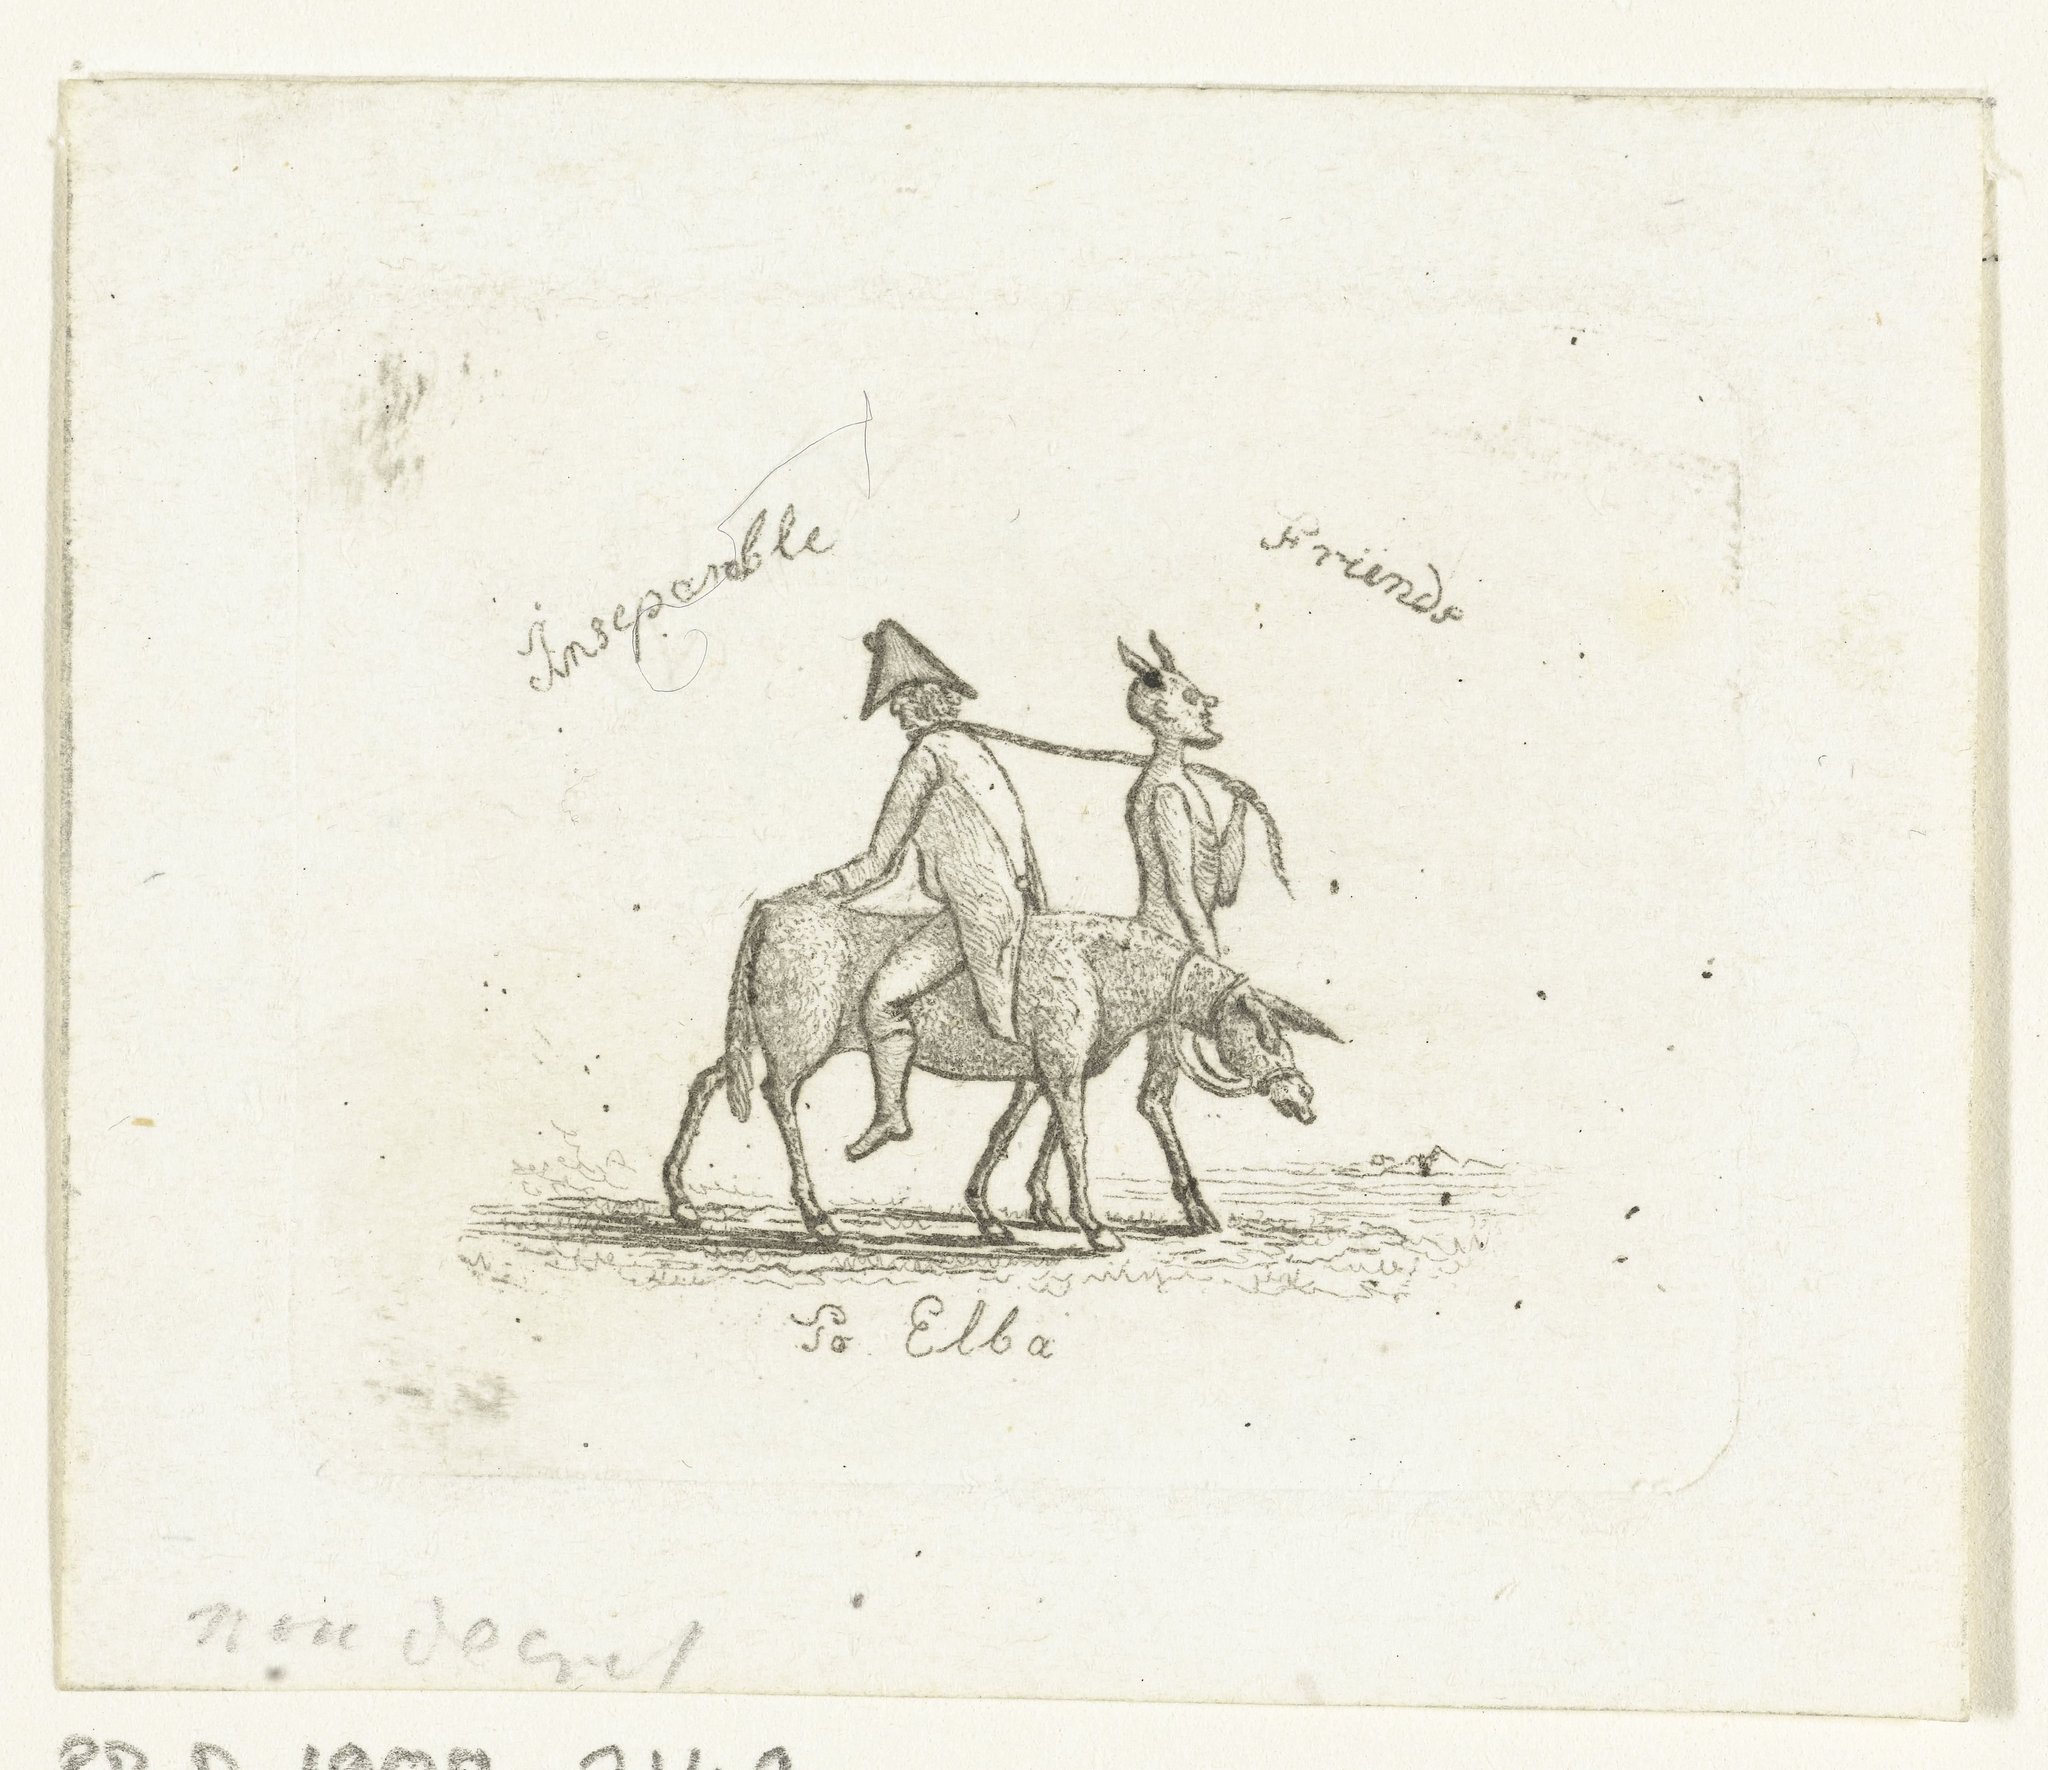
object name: print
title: To Elba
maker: ernst willem jan bagelaar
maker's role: draughtsman, print maker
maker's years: 1775-1837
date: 1814-1816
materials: paper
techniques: etching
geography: netherlands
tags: napoleon i (emperor of the french), riding a horse, ass, or mule; rider, horseman, christian religion (+ devil(s))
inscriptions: collector's mark: Lugt 2228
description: Napoleon zit verkeerd om op een ezel. De duivel trekt hem aan een touw voort. Boven de voorstelling het opschrift: Inseparable - Friends.